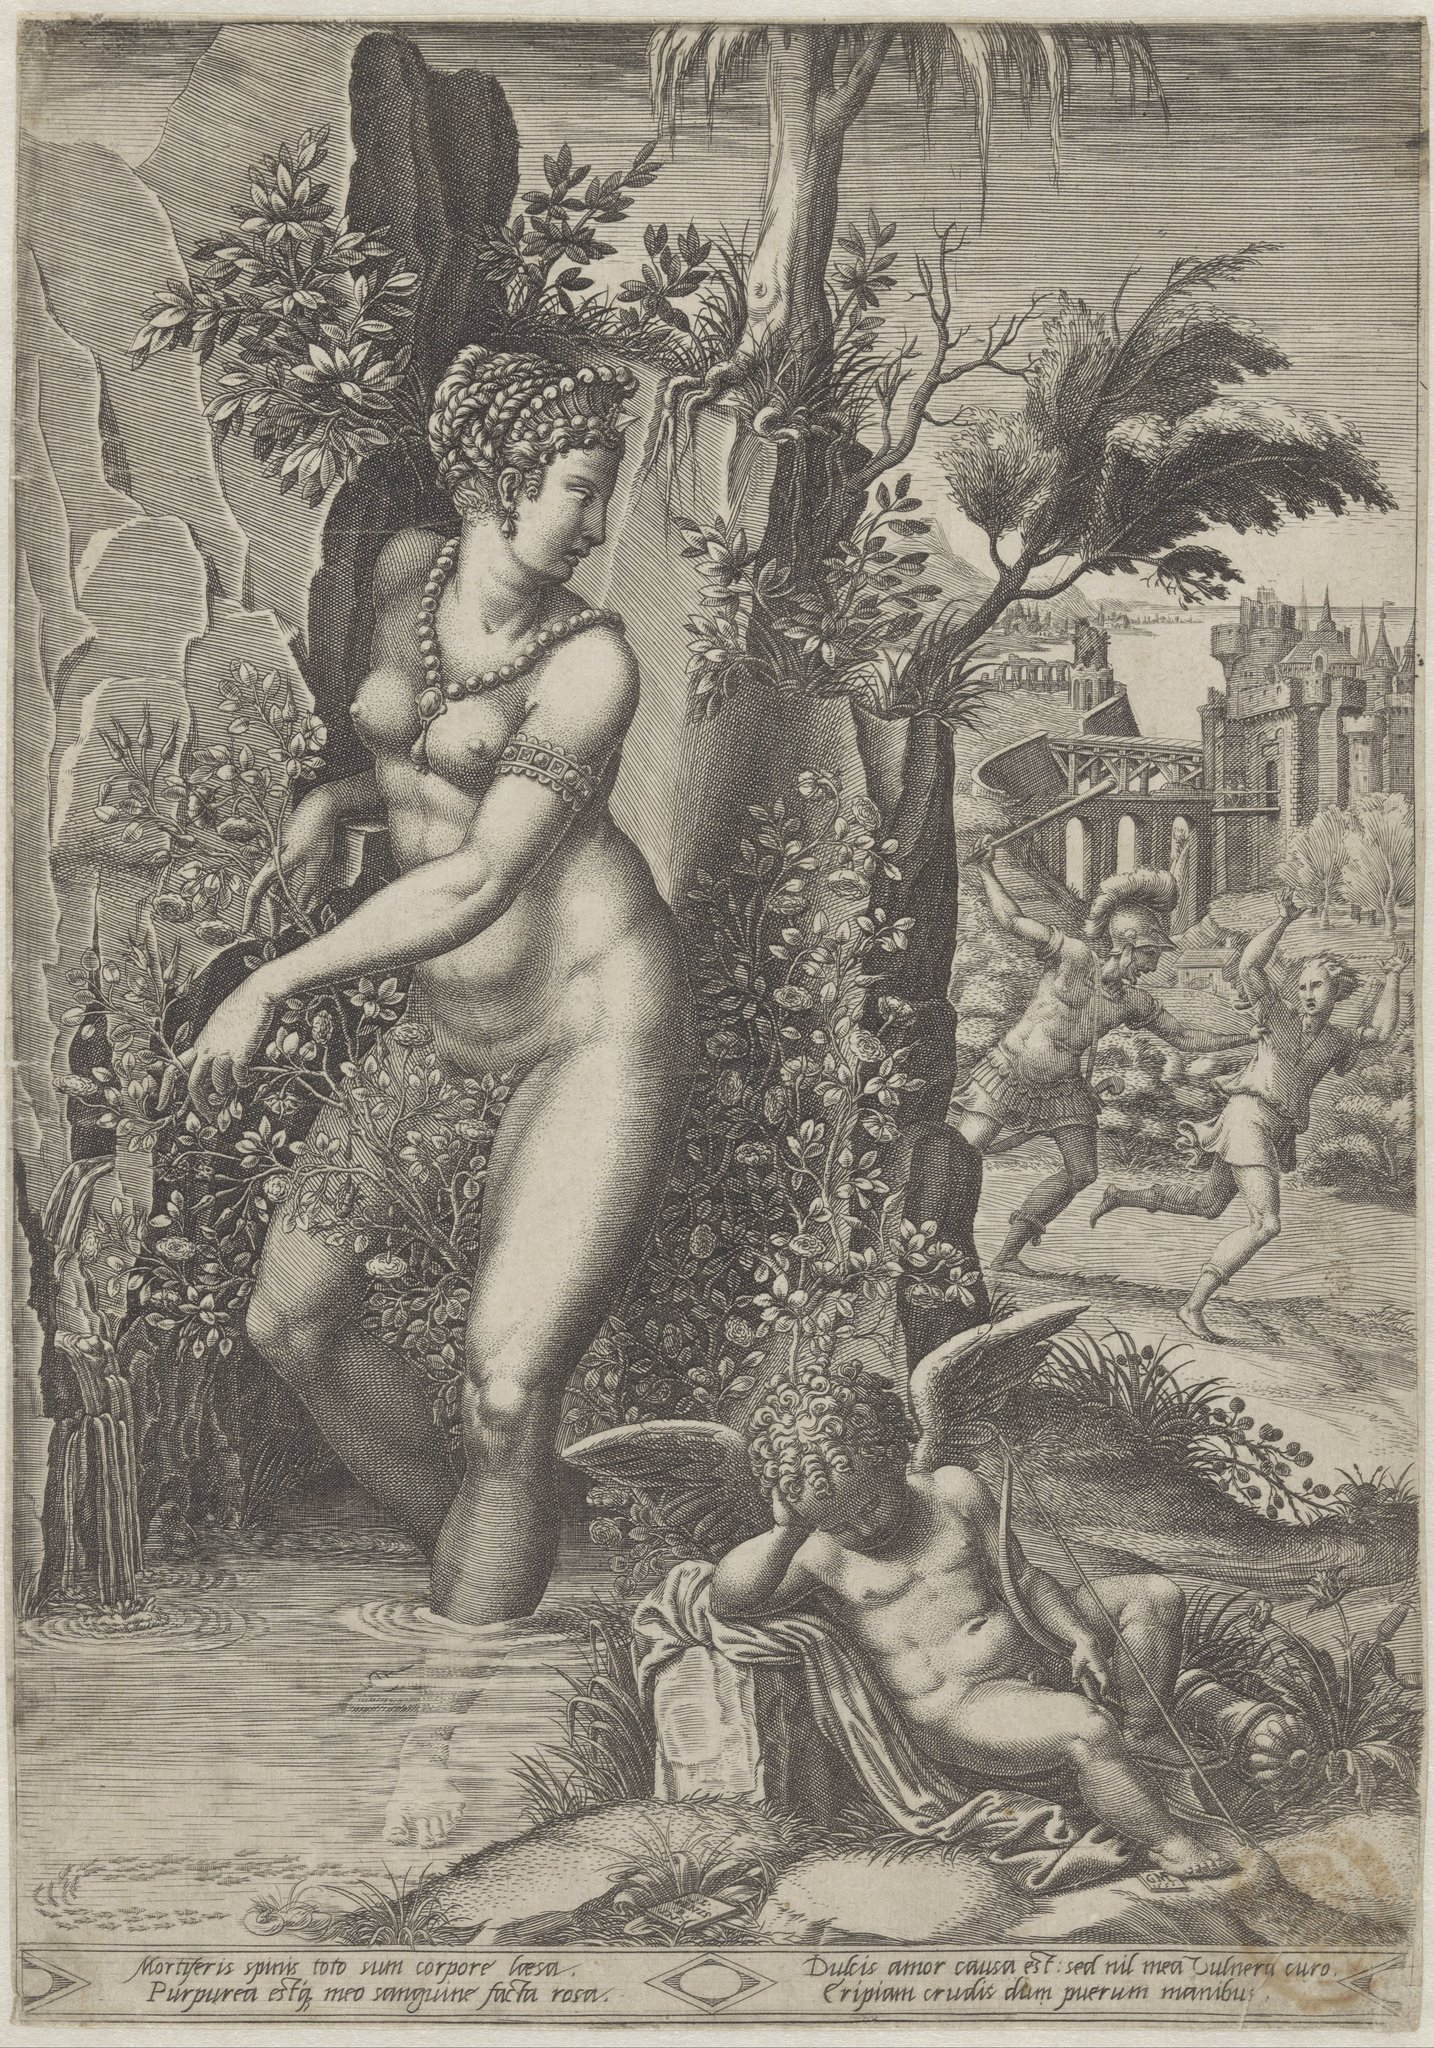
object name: print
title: Venus en de roos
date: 1530-1582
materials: paper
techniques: engraving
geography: italy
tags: venus wounded by the thorns of a rose-bush; the roses change from white to red (possibly combined with the story of adonis), mars pursuing adonis, venus and cupid (cupid not being mere attribute)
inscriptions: collector's mark: Lugt 240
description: Venus staat met haar voeten in het water, met tussen haar benen een rozenstruik, voor een grote rotspartij met begroeiing. Langs het water rechts zit Amor. Op de achtergrond wordt Adonis aangevallen door Mars. Venus kijkt om naar deze gebeurtenis. Verder in de achtergrond een stad. Onder de voorstelling vier regels Latijnse tekst in twee kolommen.